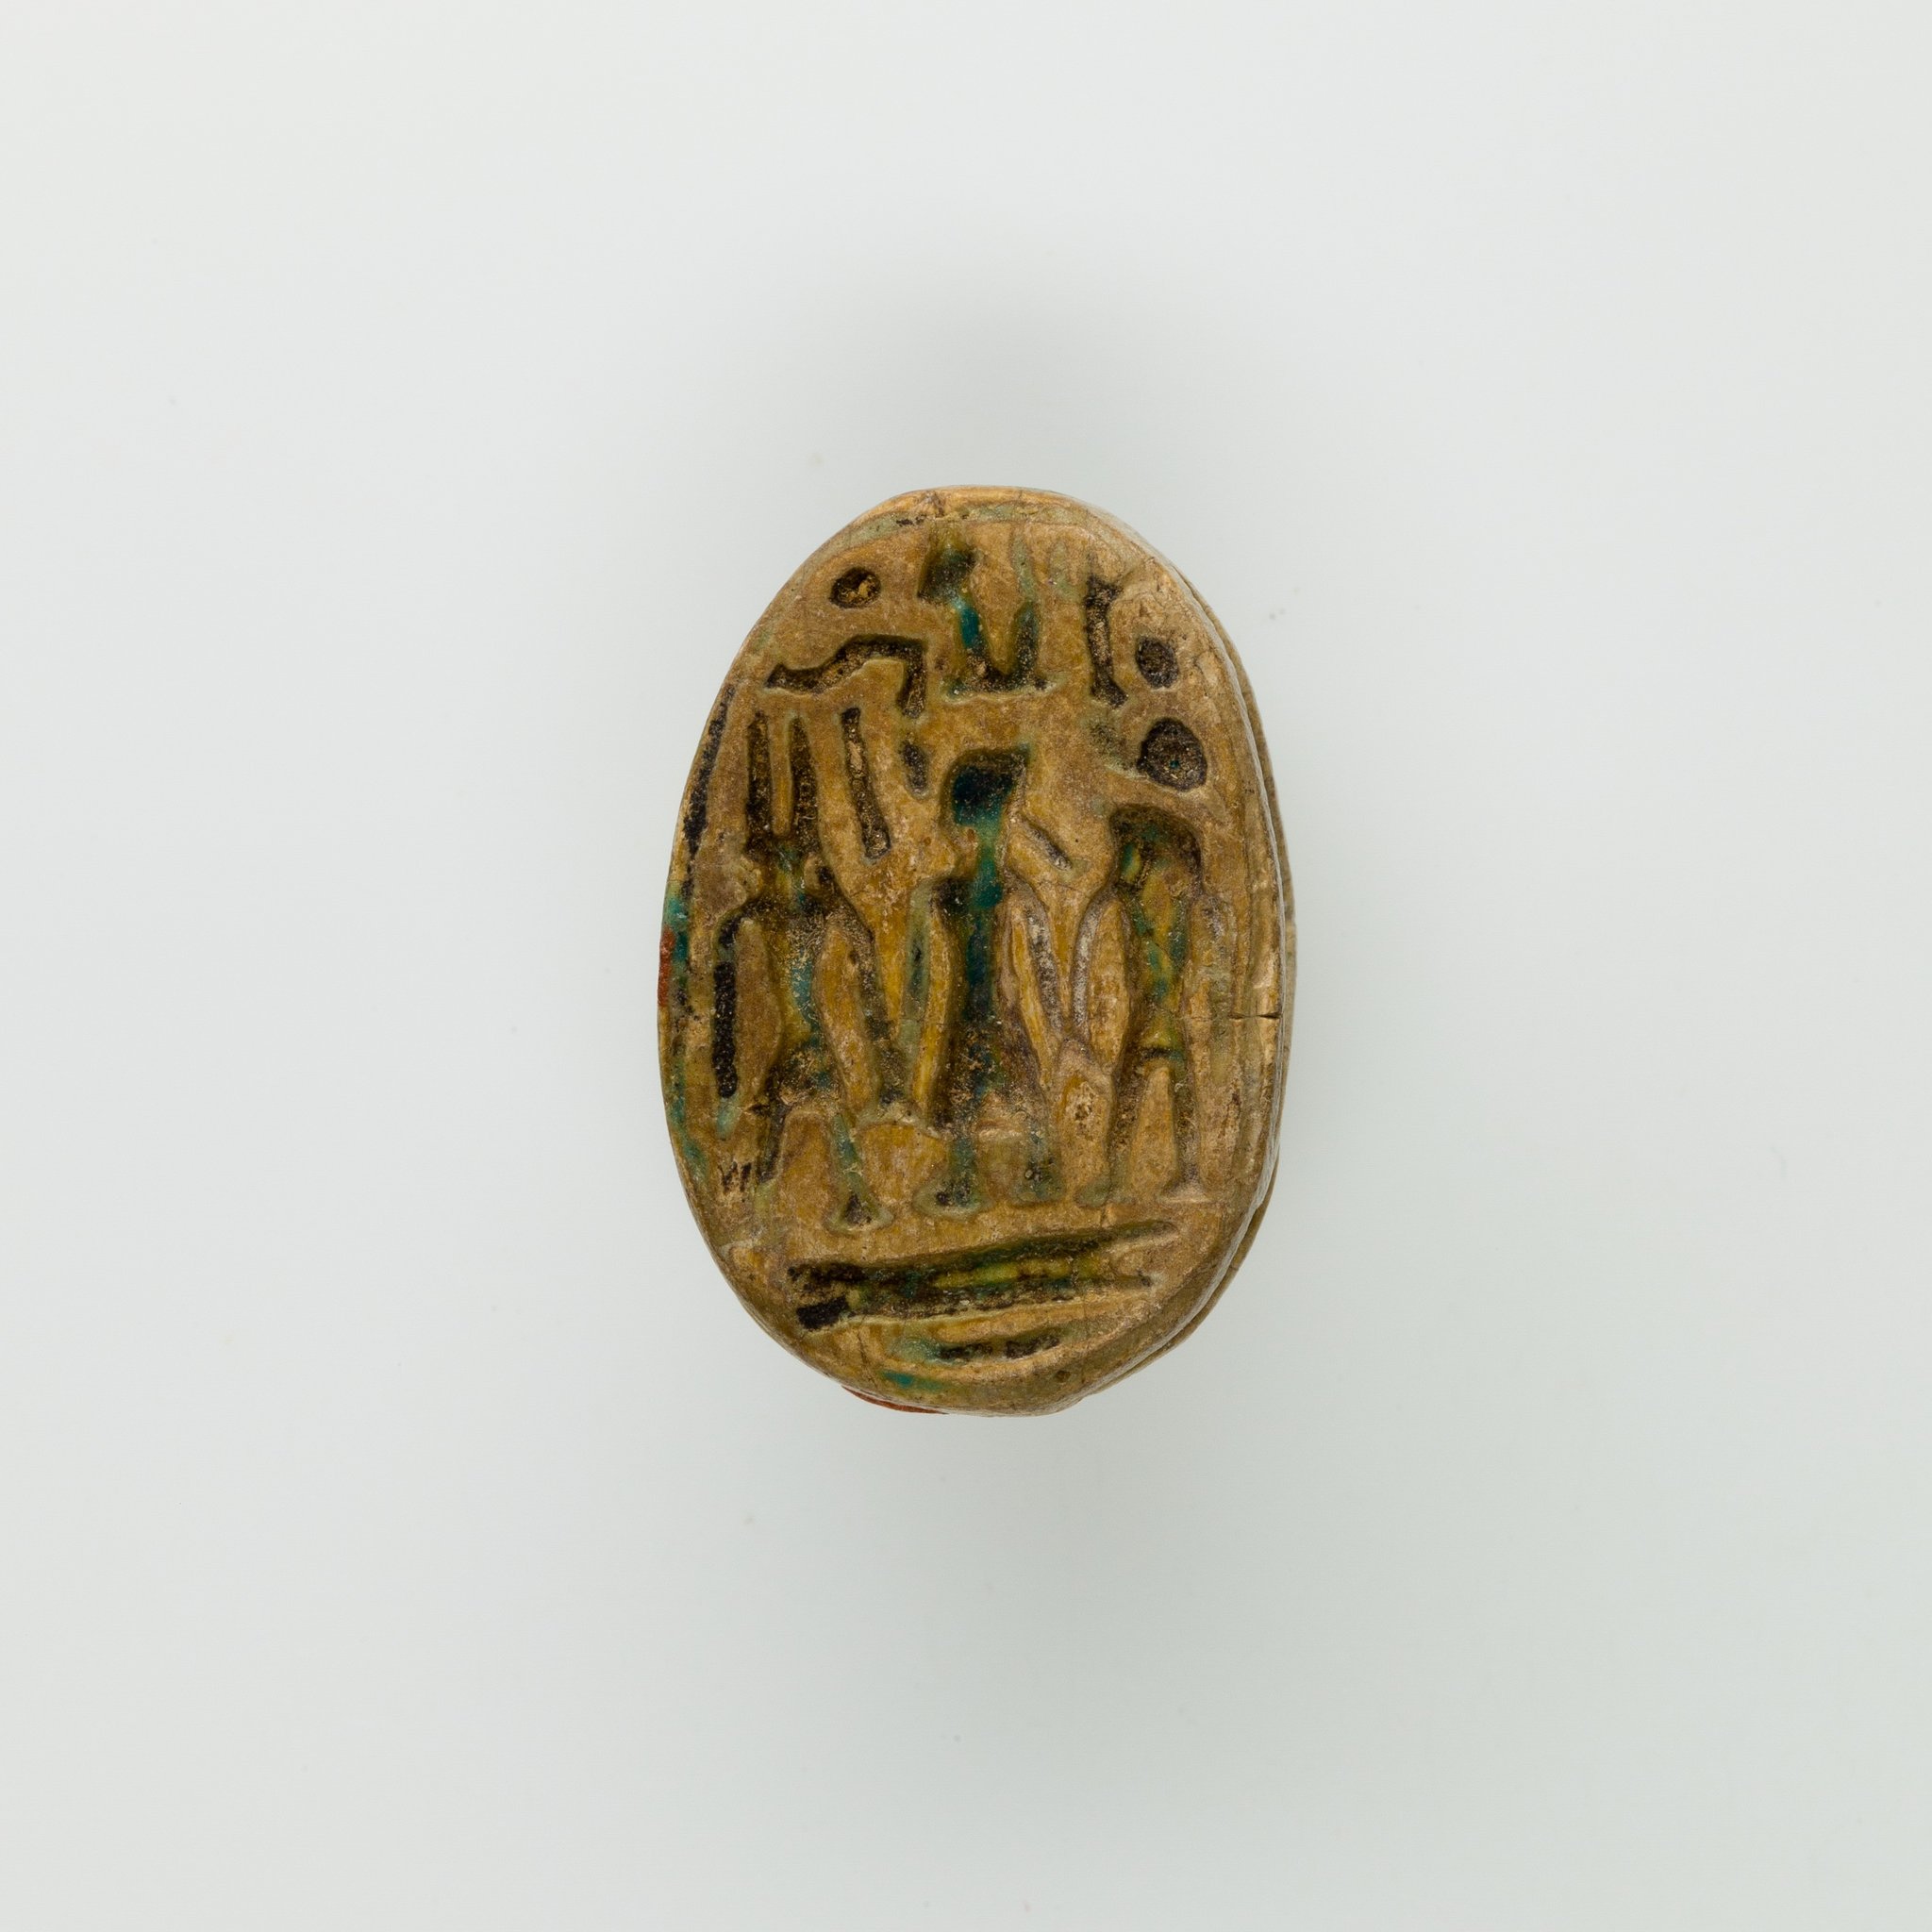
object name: scarab, ramesses ii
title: Scarab of Ramesses II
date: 1295-1070 BCE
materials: stone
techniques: glazing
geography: egypt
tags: human figures,scarabs